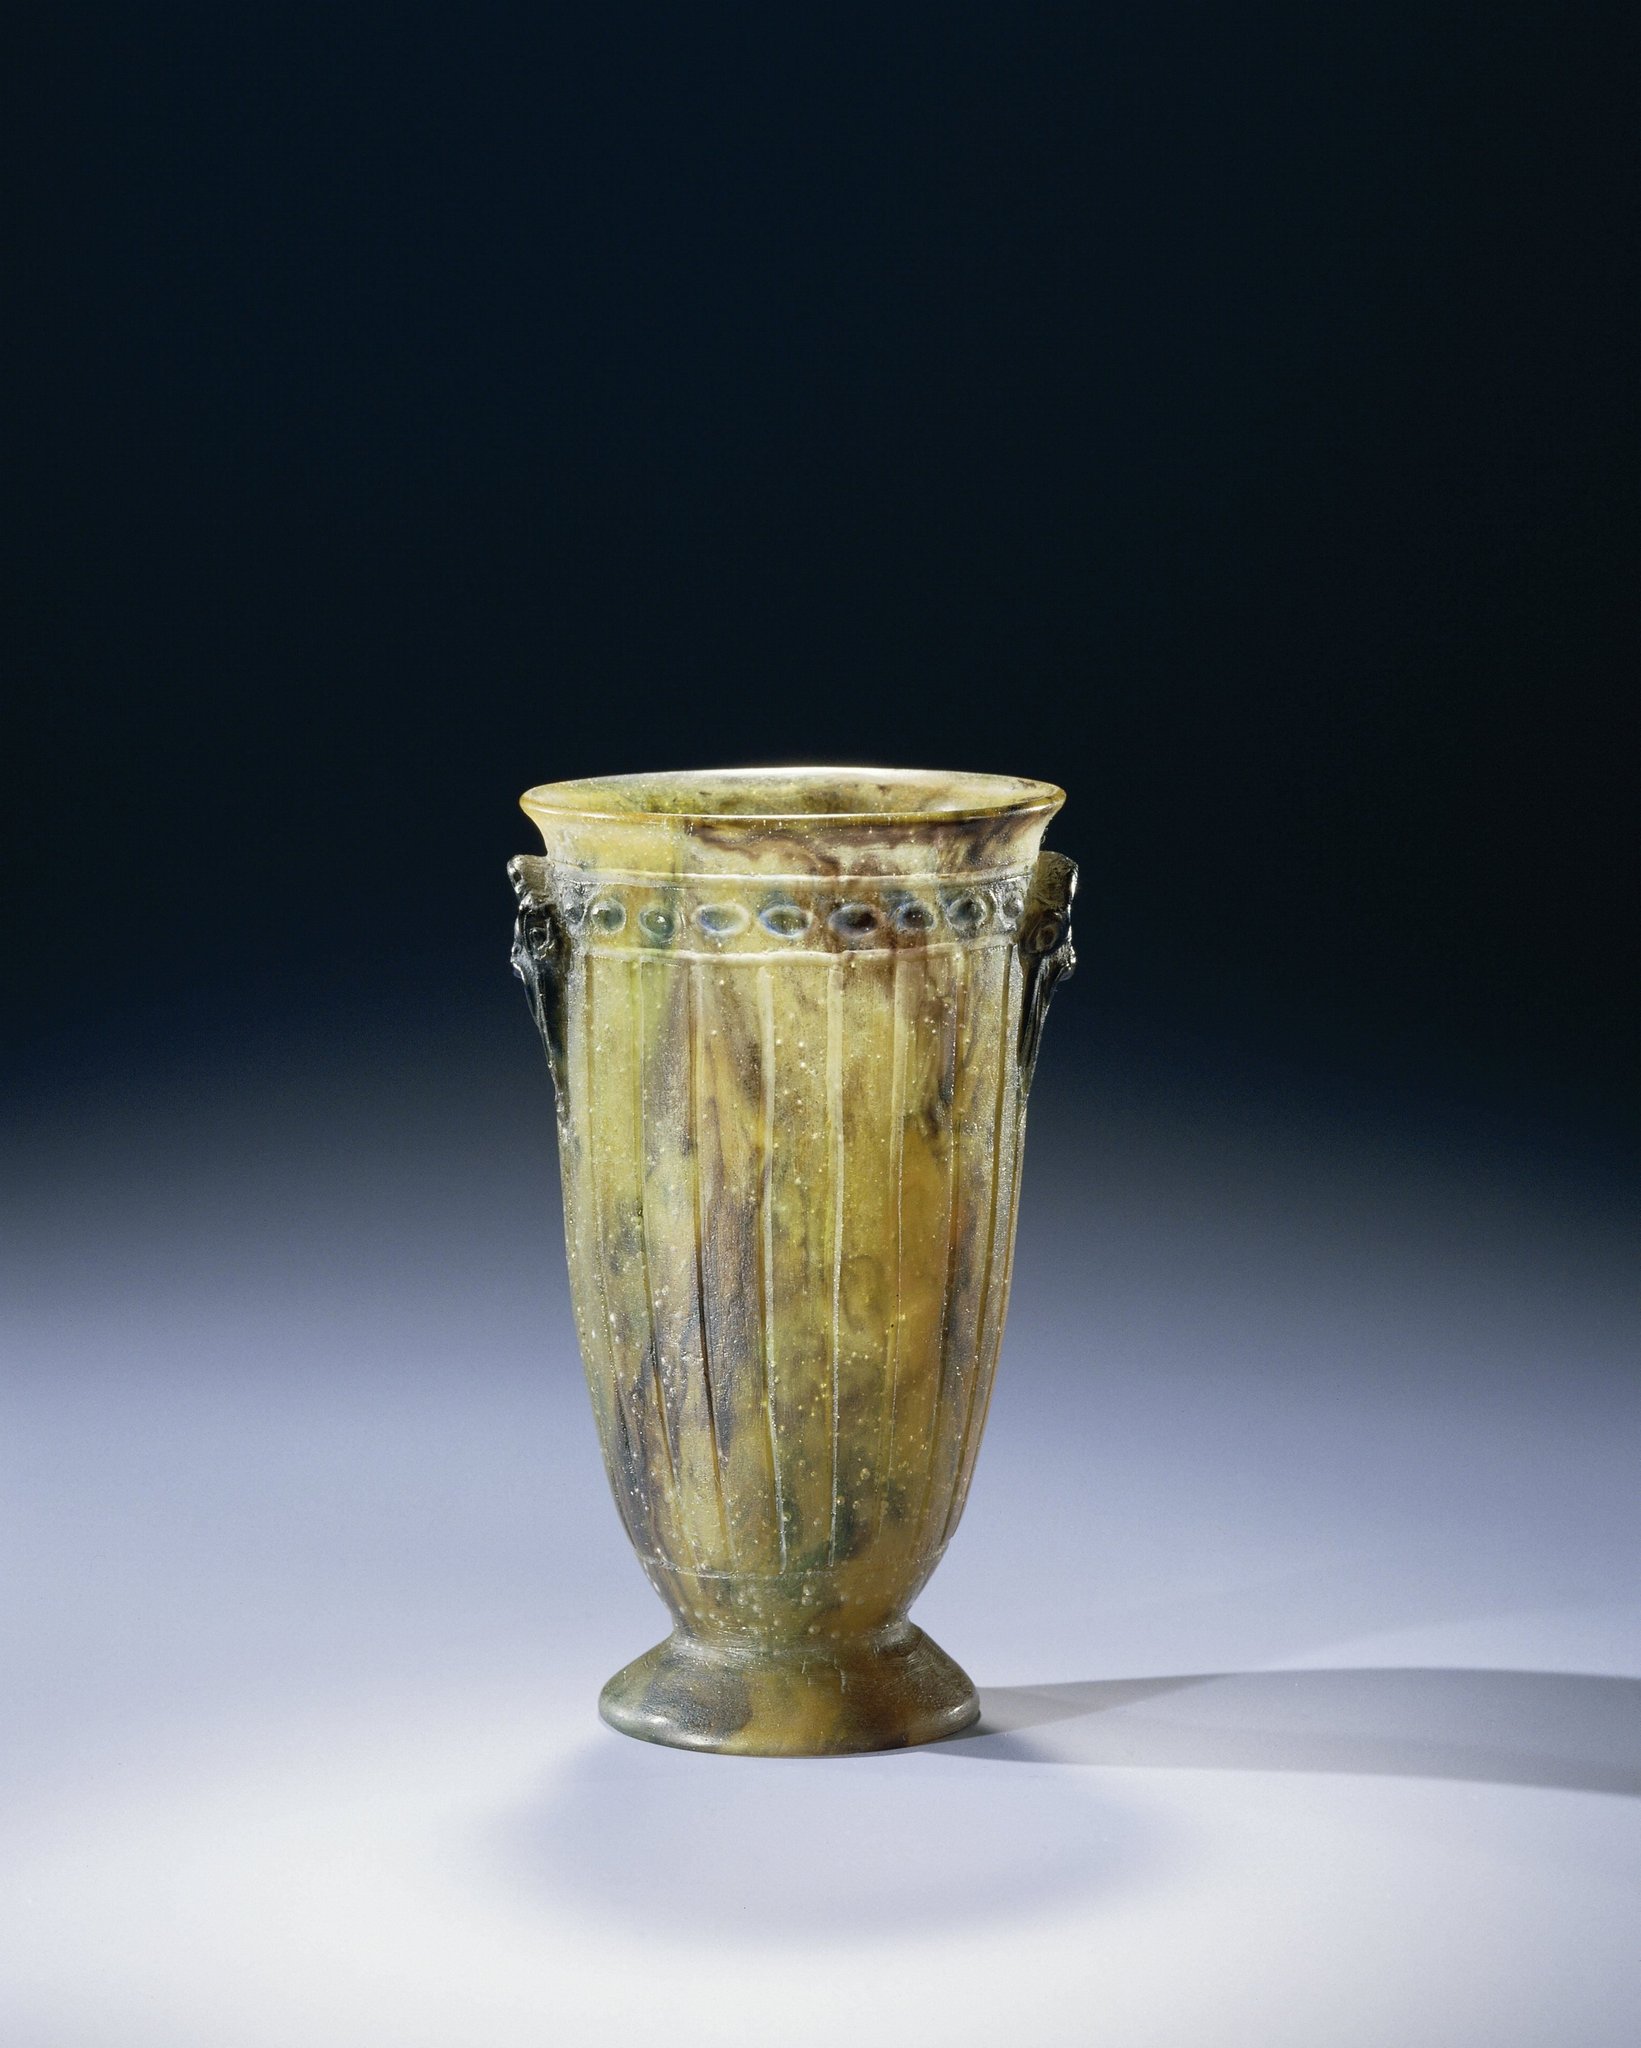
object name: vase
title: Vaas met mascarons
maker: françois-emile decorchemont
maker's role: glaskunstenaar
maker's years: 1880-1971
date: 1923-1924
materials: glass, chemical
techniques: glassblowing, grinding, pâte de verre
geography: conches-en-ouche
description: Vase. Glass. Conches, c. 1923-1924, by François Décorchemont.